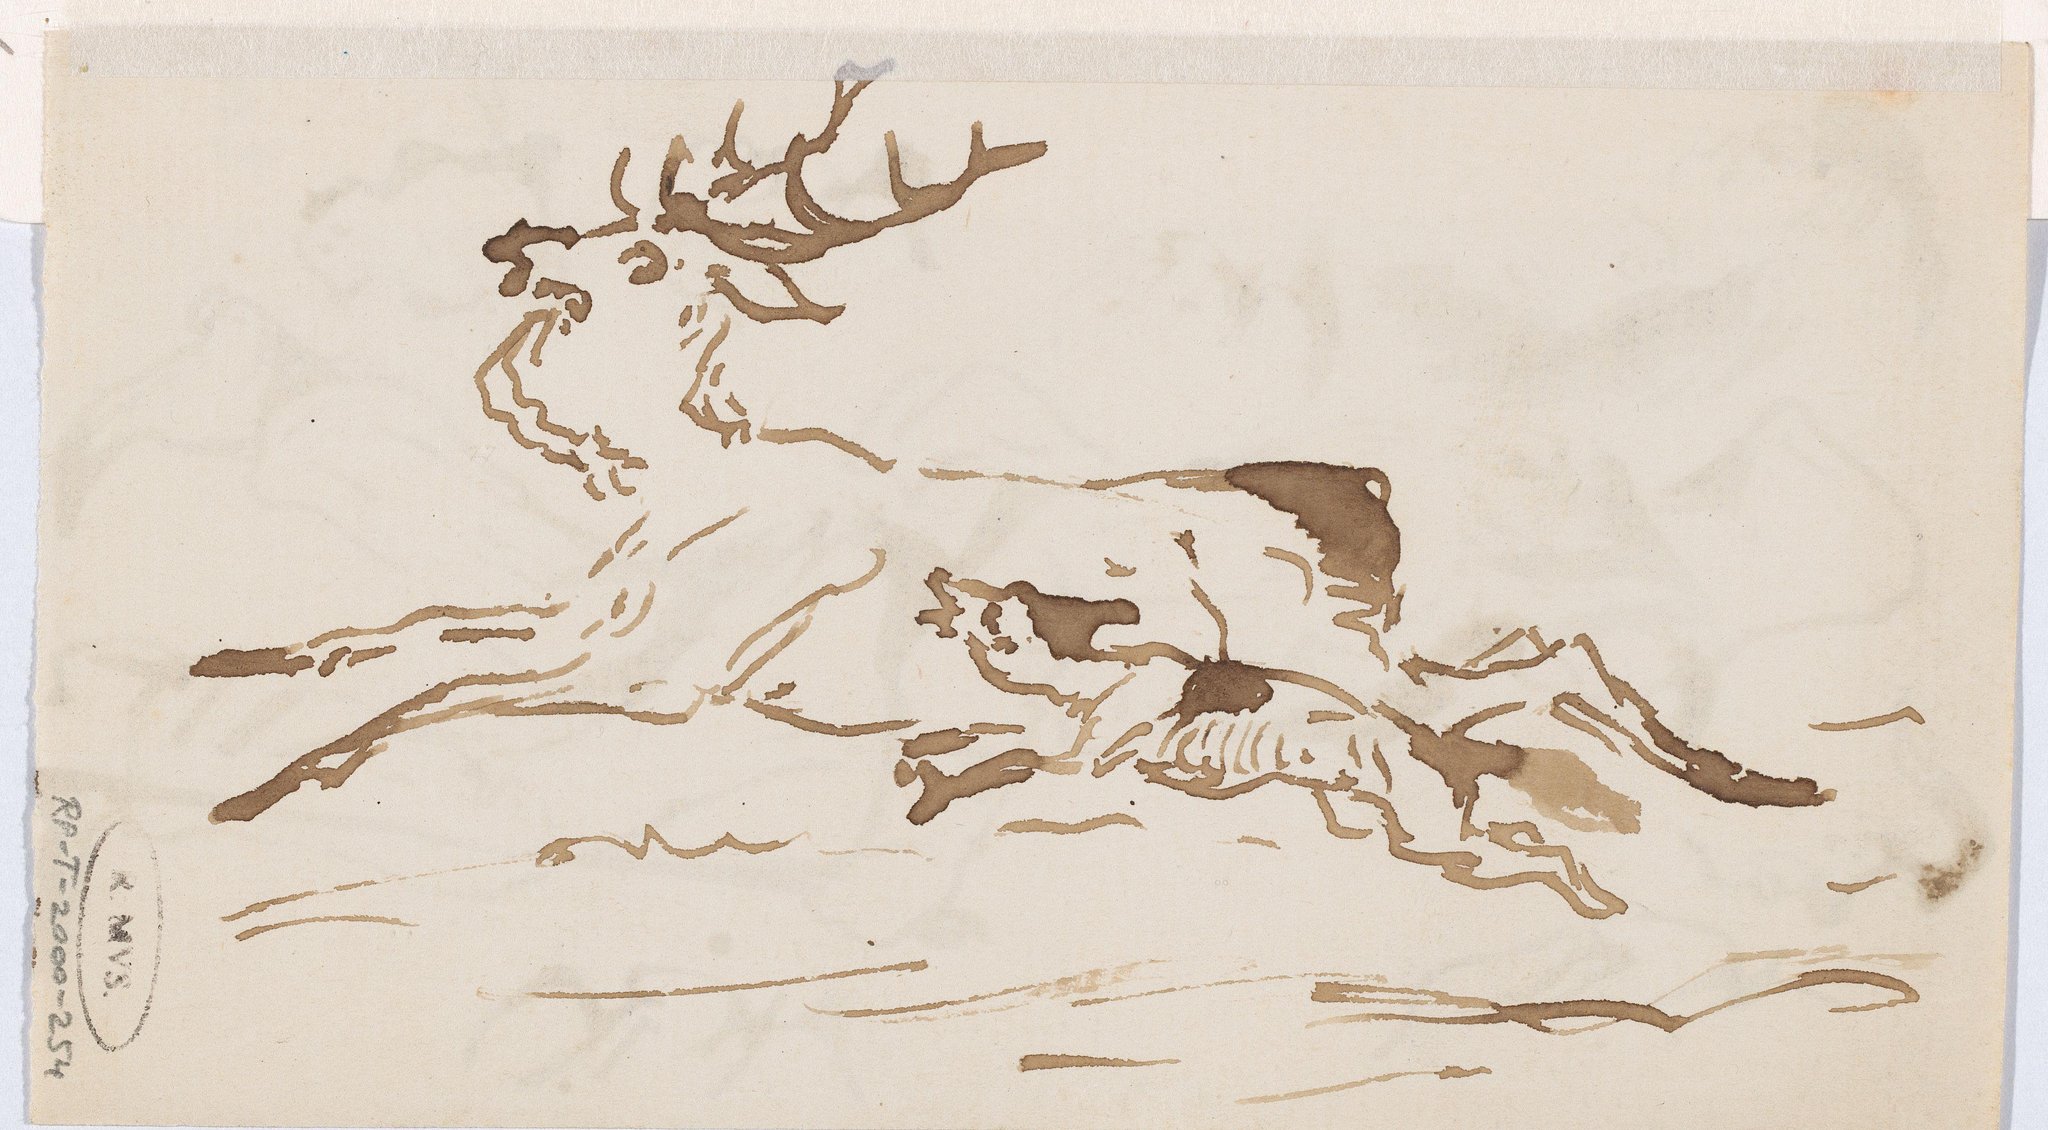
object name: drawing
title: Hert en hond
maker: johannes tavenraat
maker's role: draughtsman, painter, print maker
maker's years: 1809-1881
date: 1840-1880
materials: ink, paper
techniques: pen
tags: hoofed animals: deer, stag-hunting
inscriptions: collector's mark: Lugt 2228